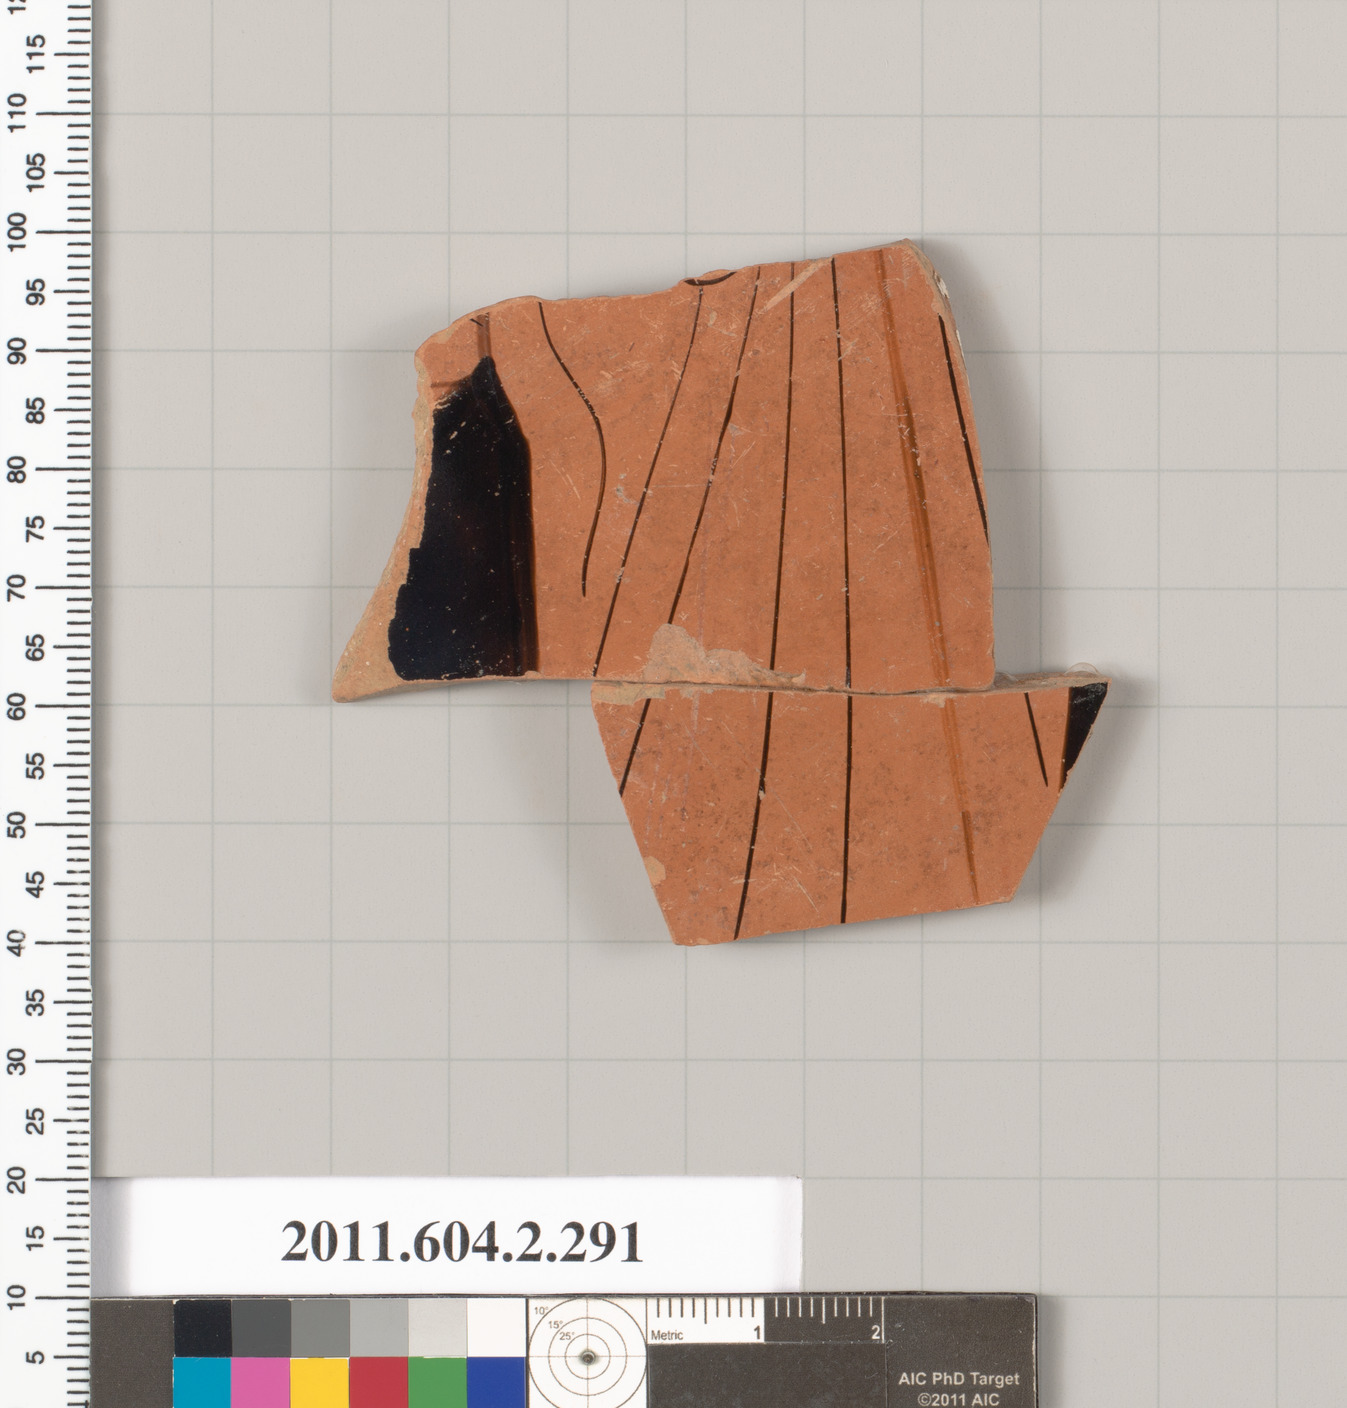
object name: column krater fragment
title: Terracotta fragment of a column-krater (bowl for mixing wine and water)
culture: greek, attic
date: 460-440 BCE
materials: terracotta